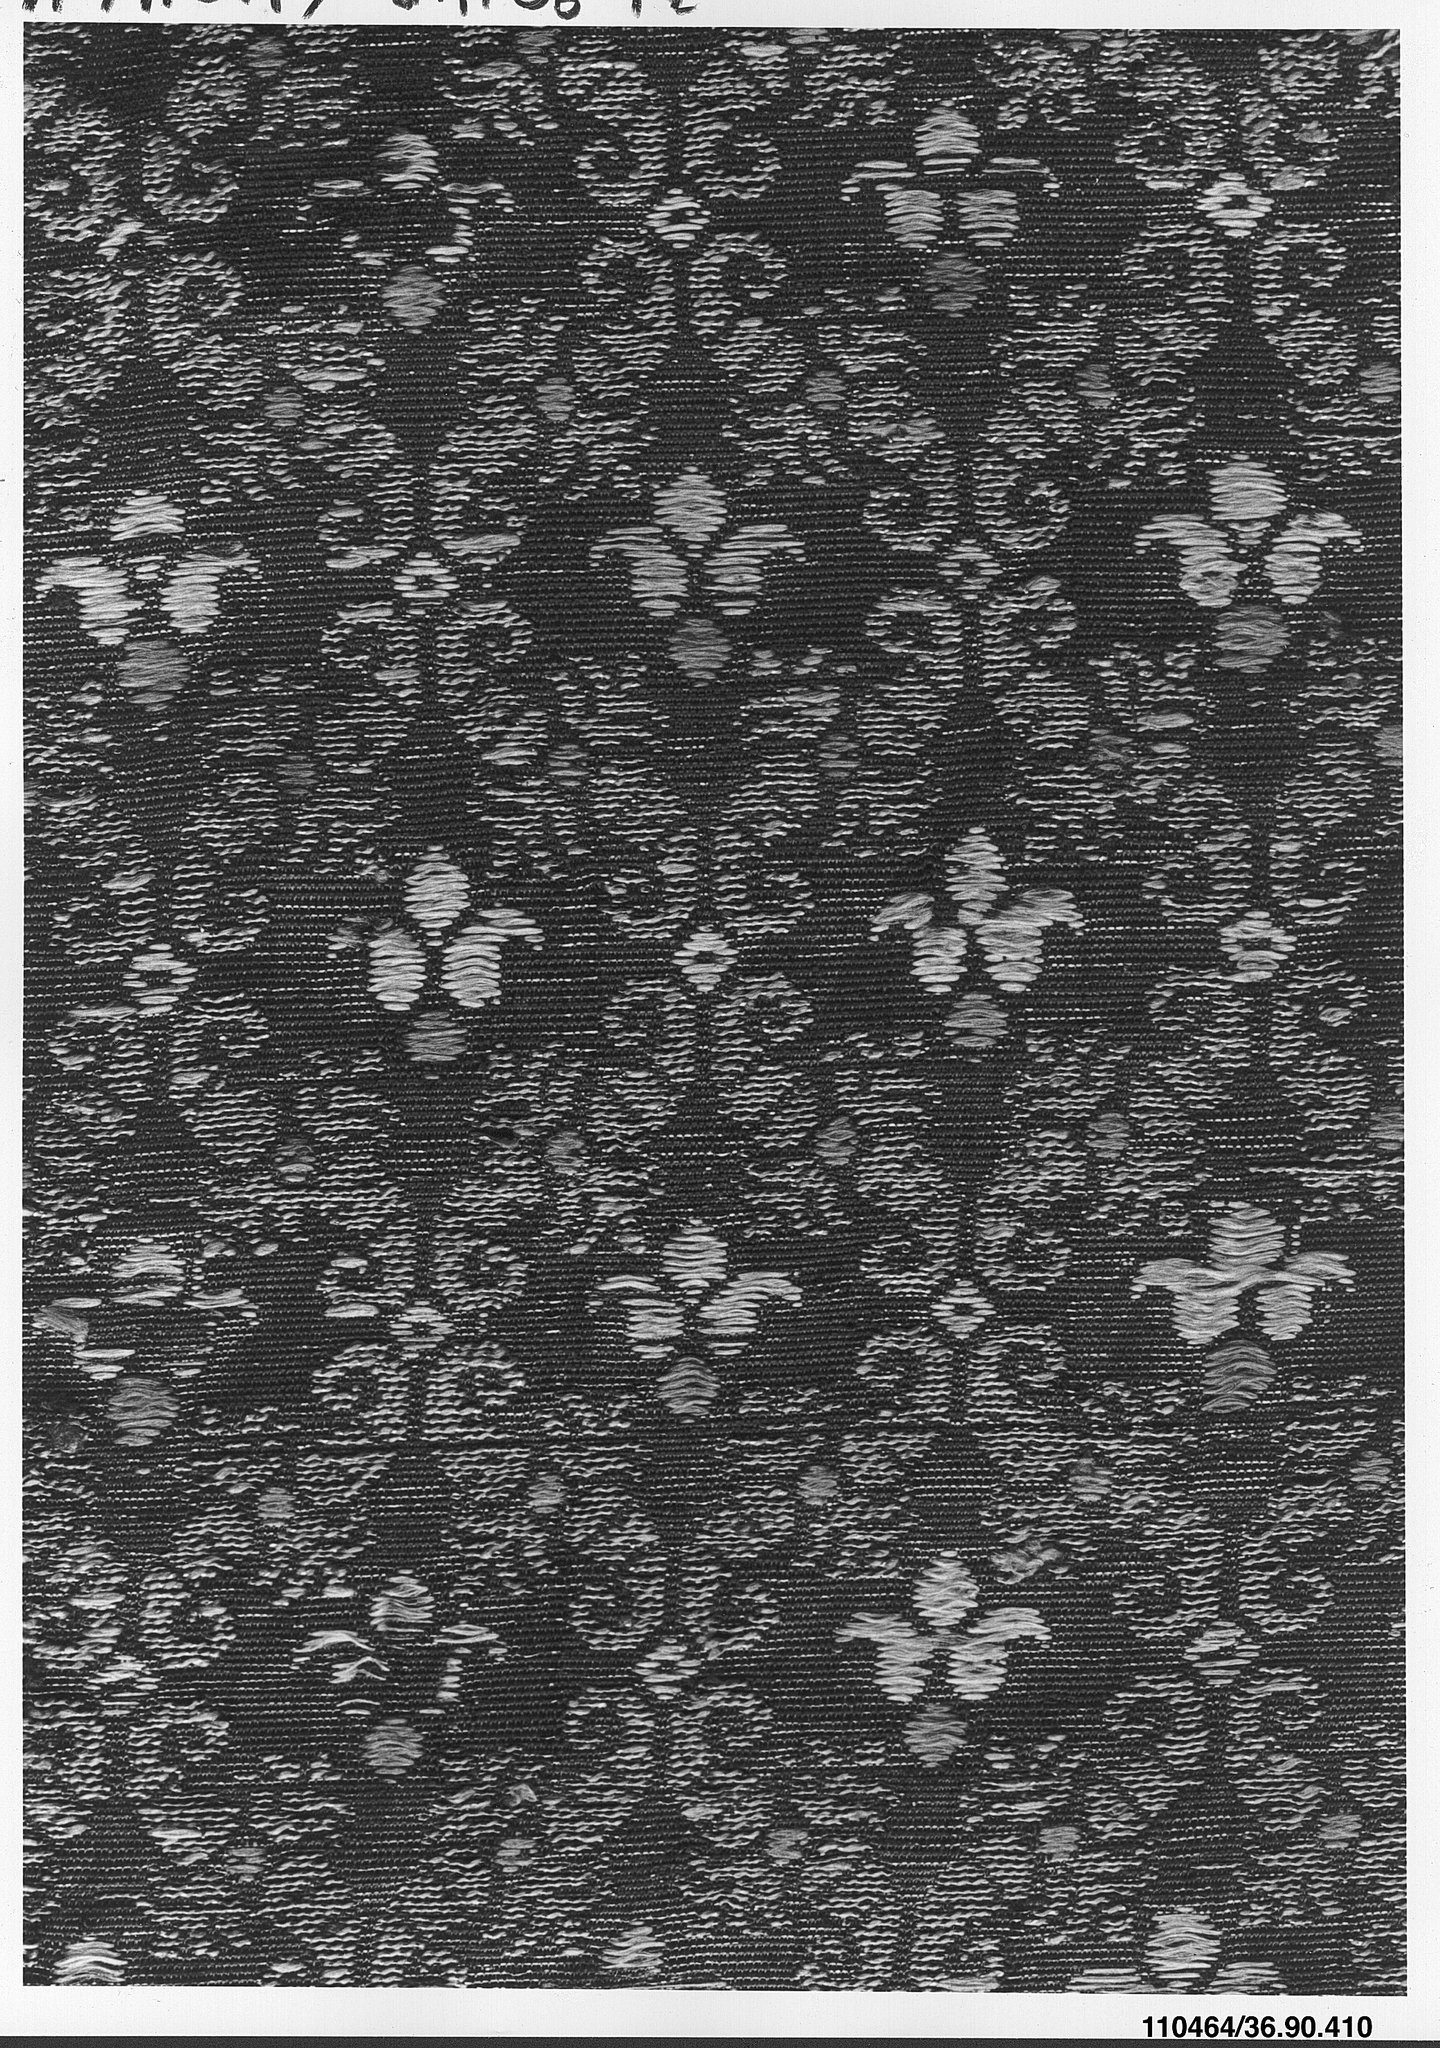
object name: piece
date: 1501-1700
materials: metal thread, silk